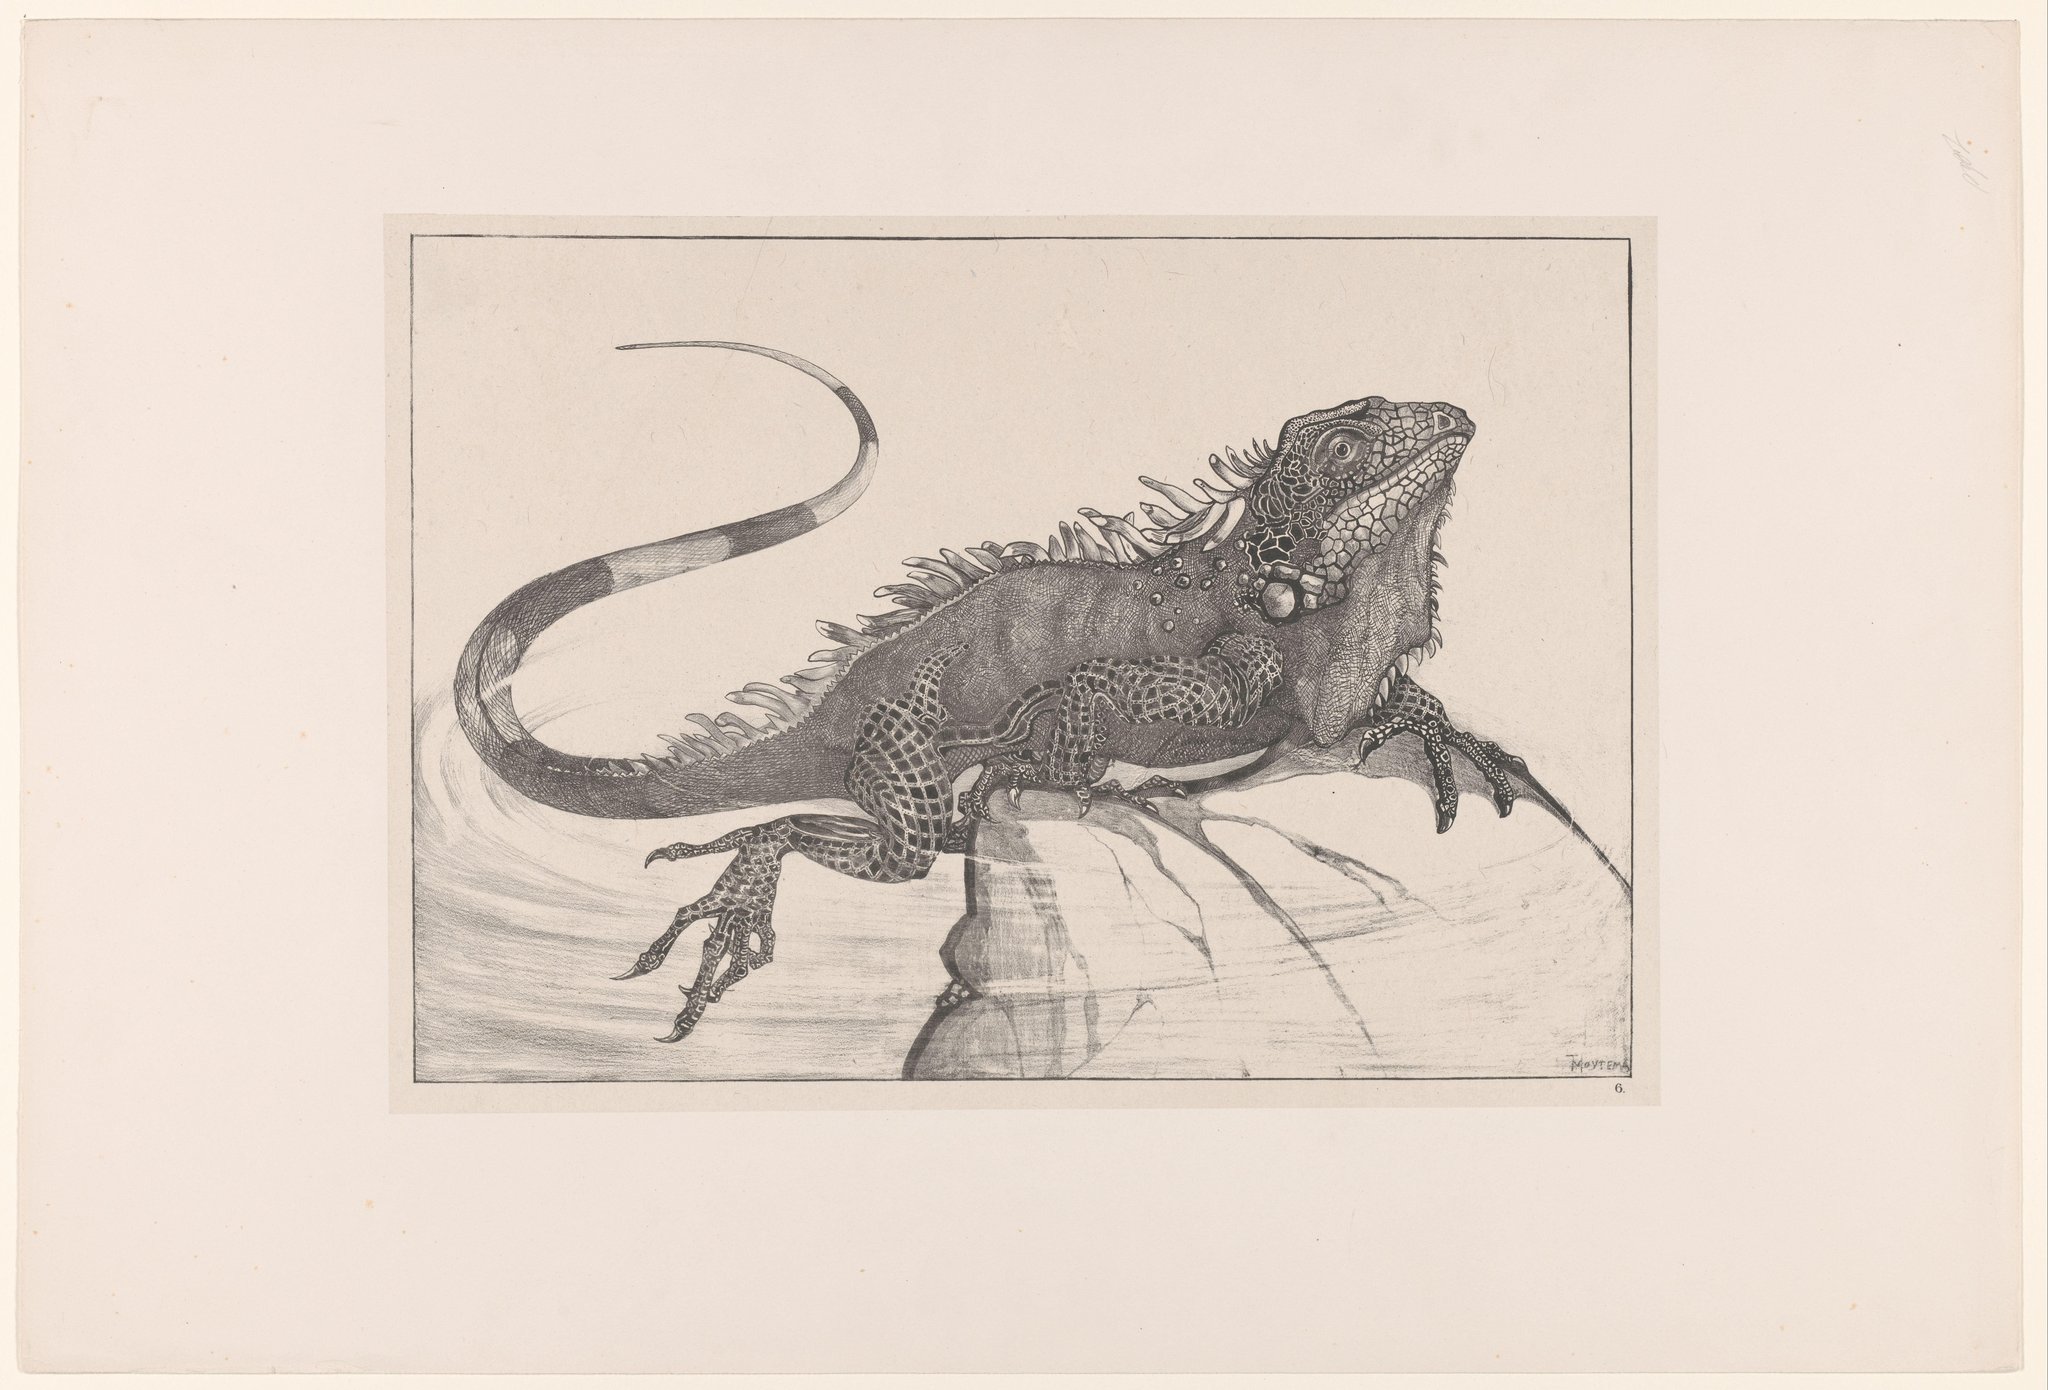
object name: print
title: Dierstudies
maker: theo van hoytema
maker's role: draughtsman, painter, print maker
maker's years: 1863-1917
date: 1898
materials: paper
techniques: lithograph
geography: hilversum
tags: lizards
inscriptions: collector's mark: Lugt 2233